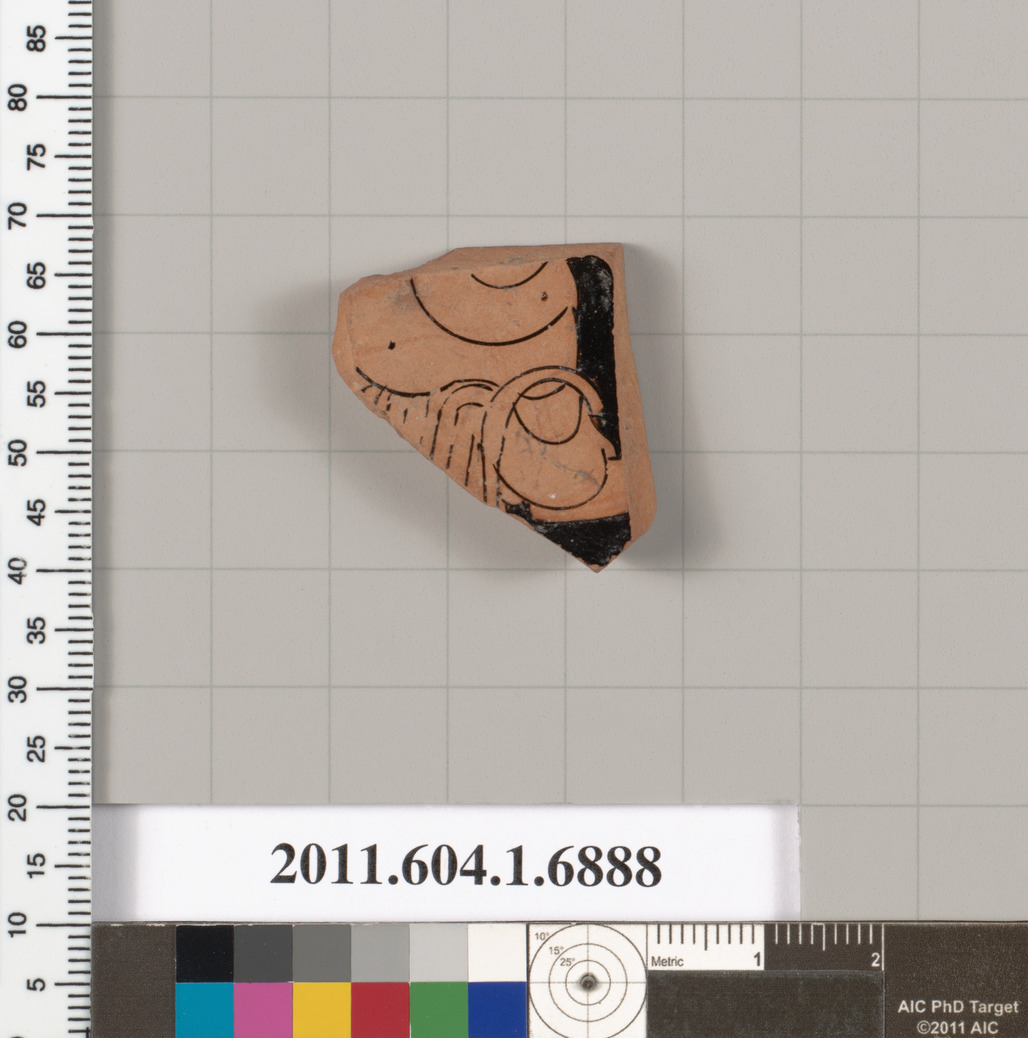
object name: kylix fragment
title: Terracotta fragment of a kylix (drinking cup)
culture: greek, attic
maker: brygos painter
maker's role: artist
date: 490-470 BCE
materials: terracotta